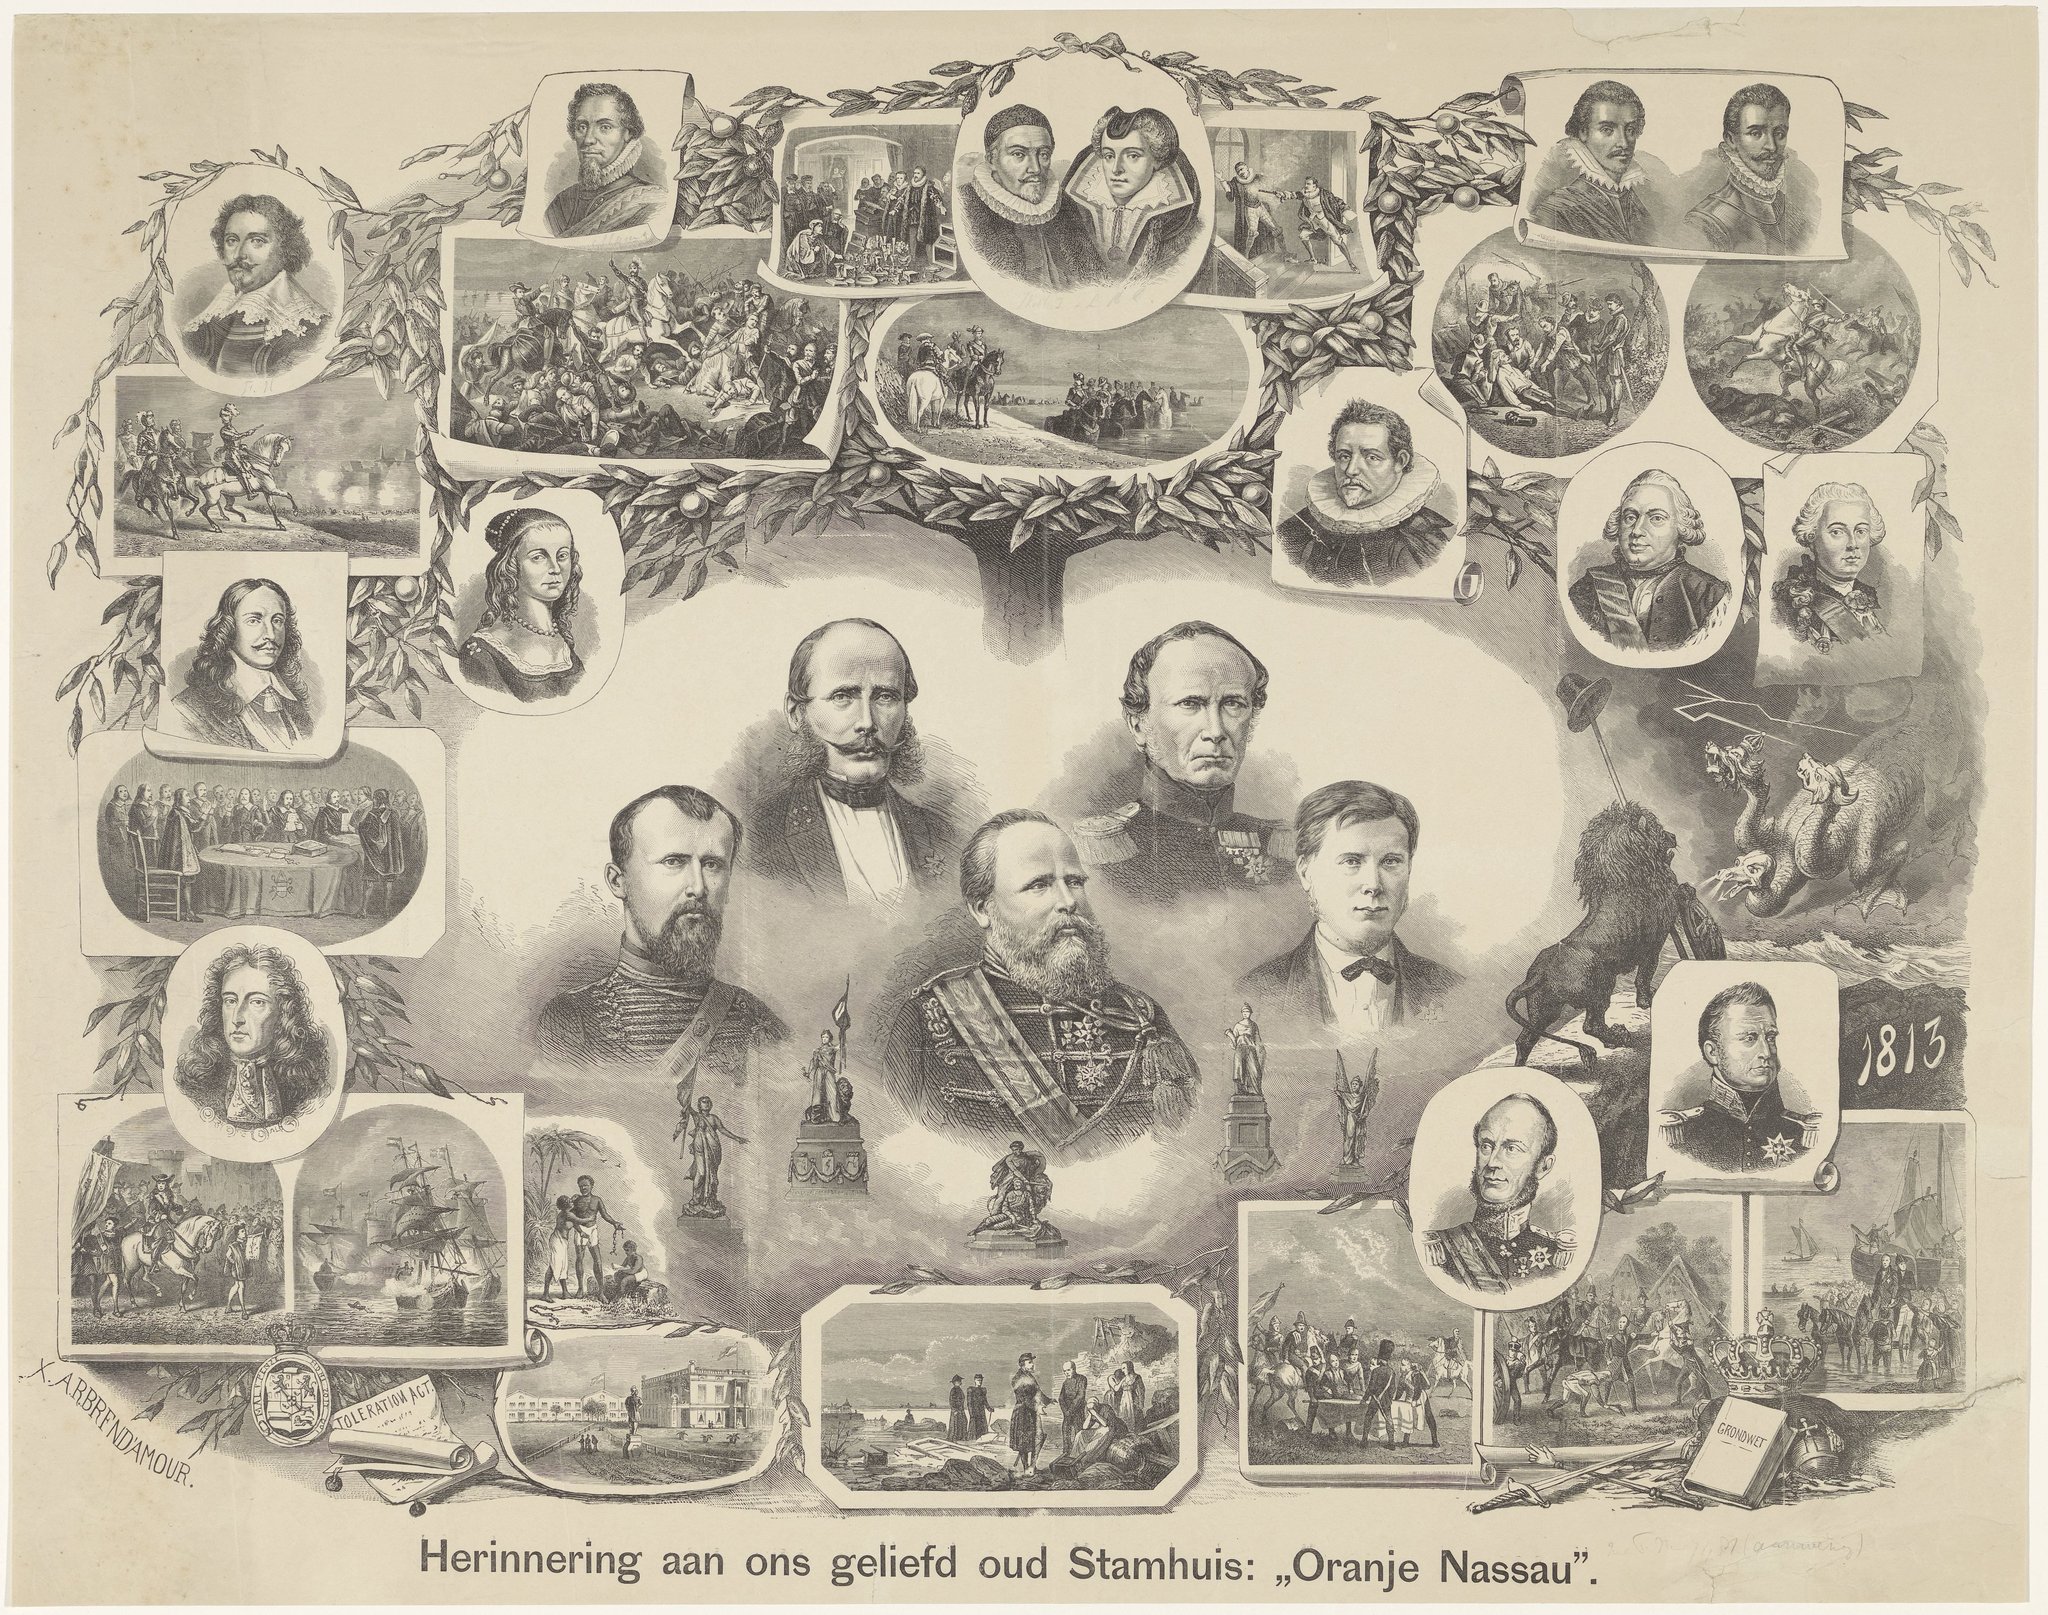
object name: print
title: Gedenkplaat bij het 25-jarige regeringsjubileum van koning Willem III 1849-1874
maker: richard brendamour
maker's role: print maker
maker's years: 1831-1915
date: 1874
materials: paper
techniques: engraving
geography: dusseldorf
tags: the hague, brussels, willem iii (koning der nederlanden), willem (prins der nederlanden), hendrik (prins der nederlanden), frederik (prins der nederlanden), historical persons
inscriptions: collector's mark: Lugt 2228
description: Gedenkplaat bij de viering van het 25-jarige regeringsjubileum van koning Willem III, 12 mei 1874. Centraal de portretten van de koning, de kroonprins en de prinsen Hendrik, Frederik en Alexander. Hieromheen portretten uit het huis van Oranje-Nassau en scènes van belangrijke historische gebeurtenissen vanaf de tijd van Willem van Oranje.